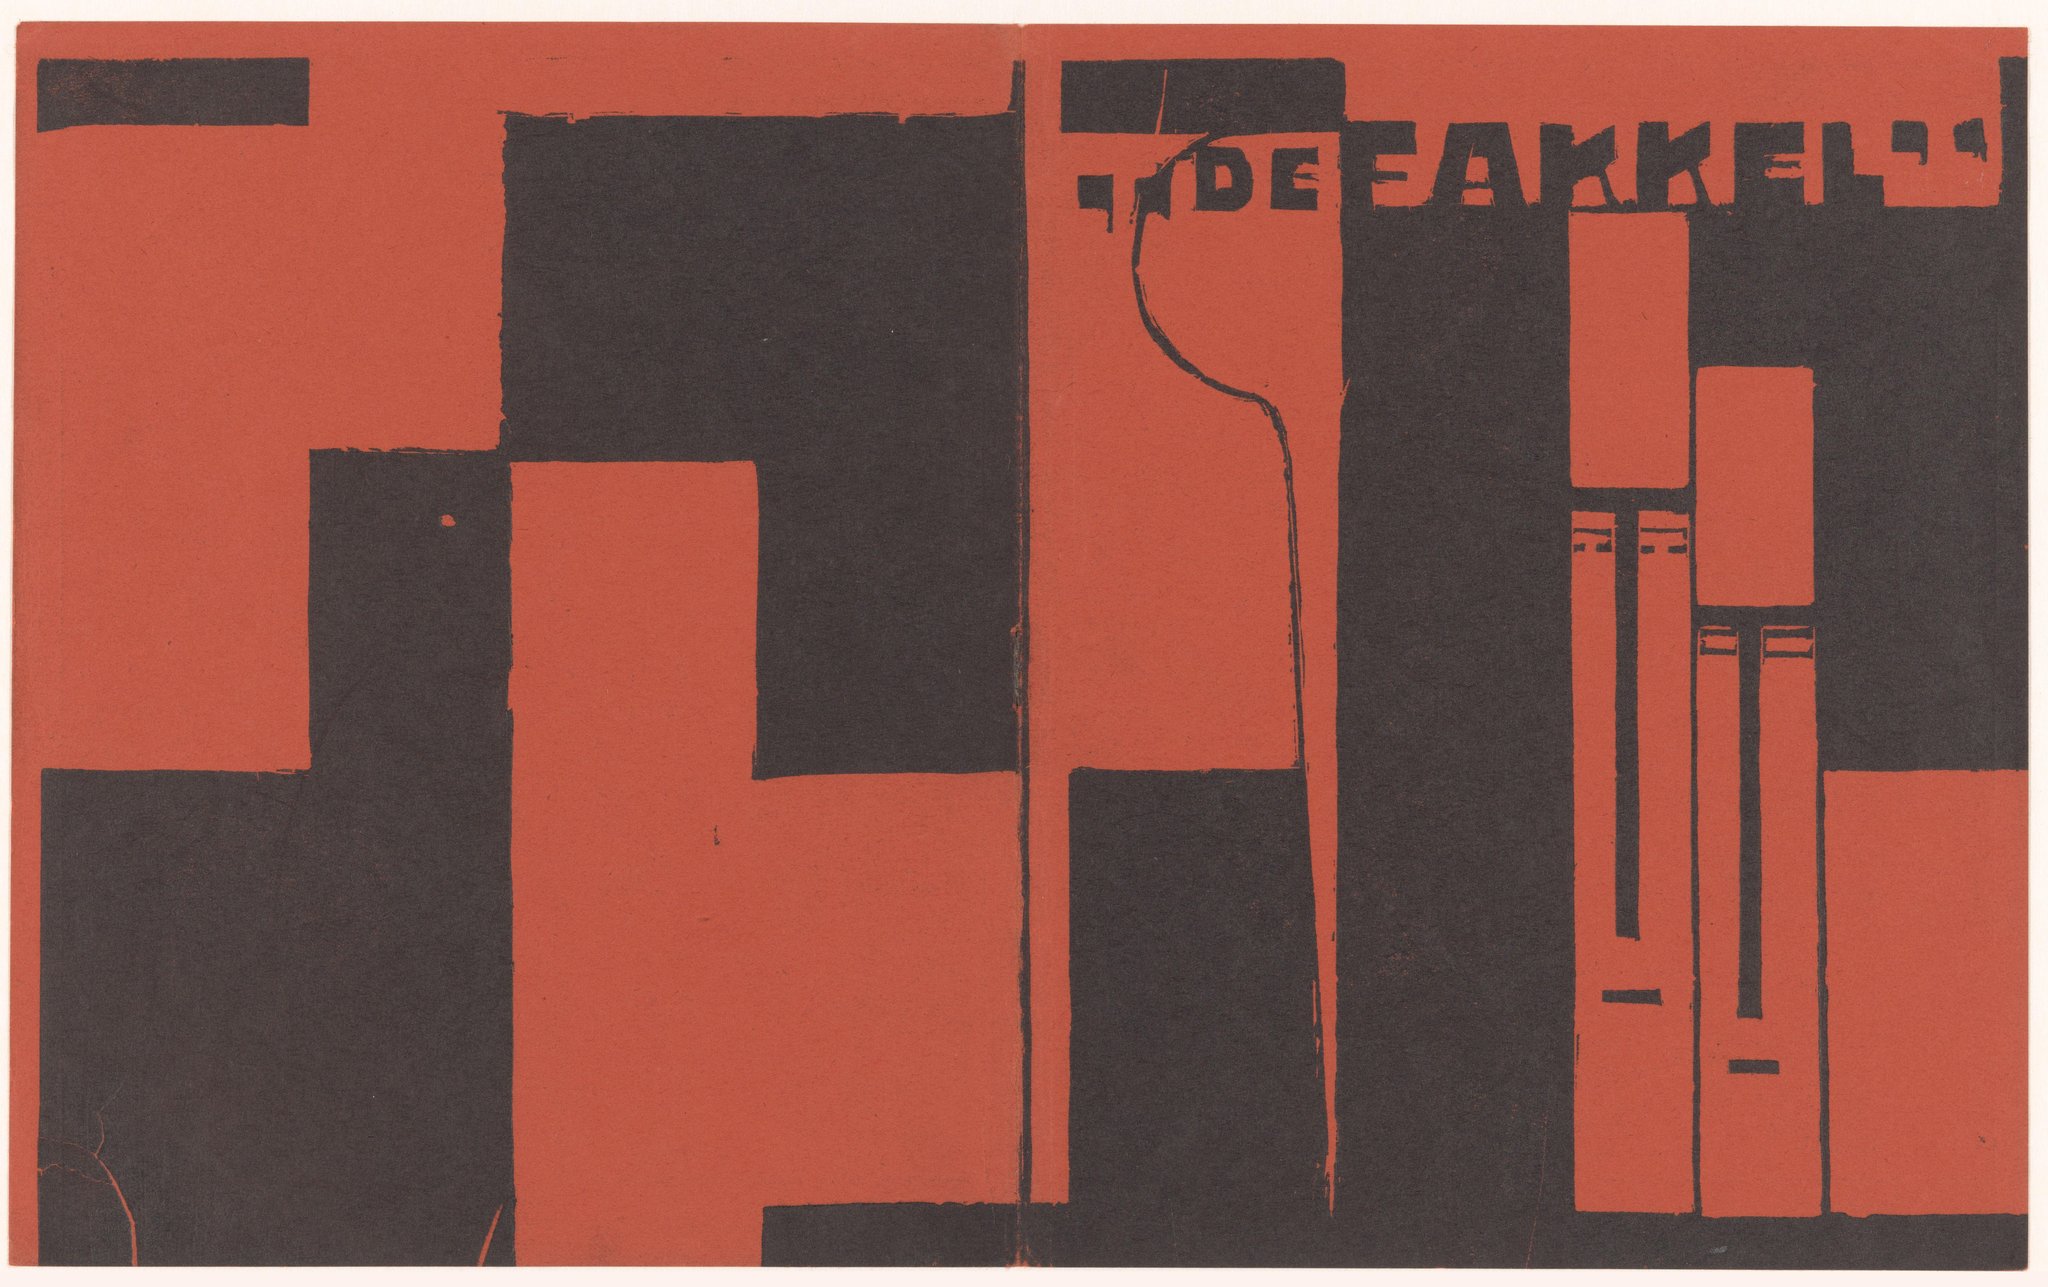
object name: print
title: De Fakkel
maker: hendrik chabot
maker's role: print maker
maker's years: 1894-1949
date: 1925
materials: paper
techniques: woodcut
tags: head (human), quadrilateral (~ planimetry, geometry)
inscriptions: collector's mark: Lugt 2228, collector's mark: Lugt 2760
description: Prent gebruikt voor 'De Fakkel', het tijdschrift van de Academie van Beeldende Kunsten en Technische Wetenschappen in Rotterdam.